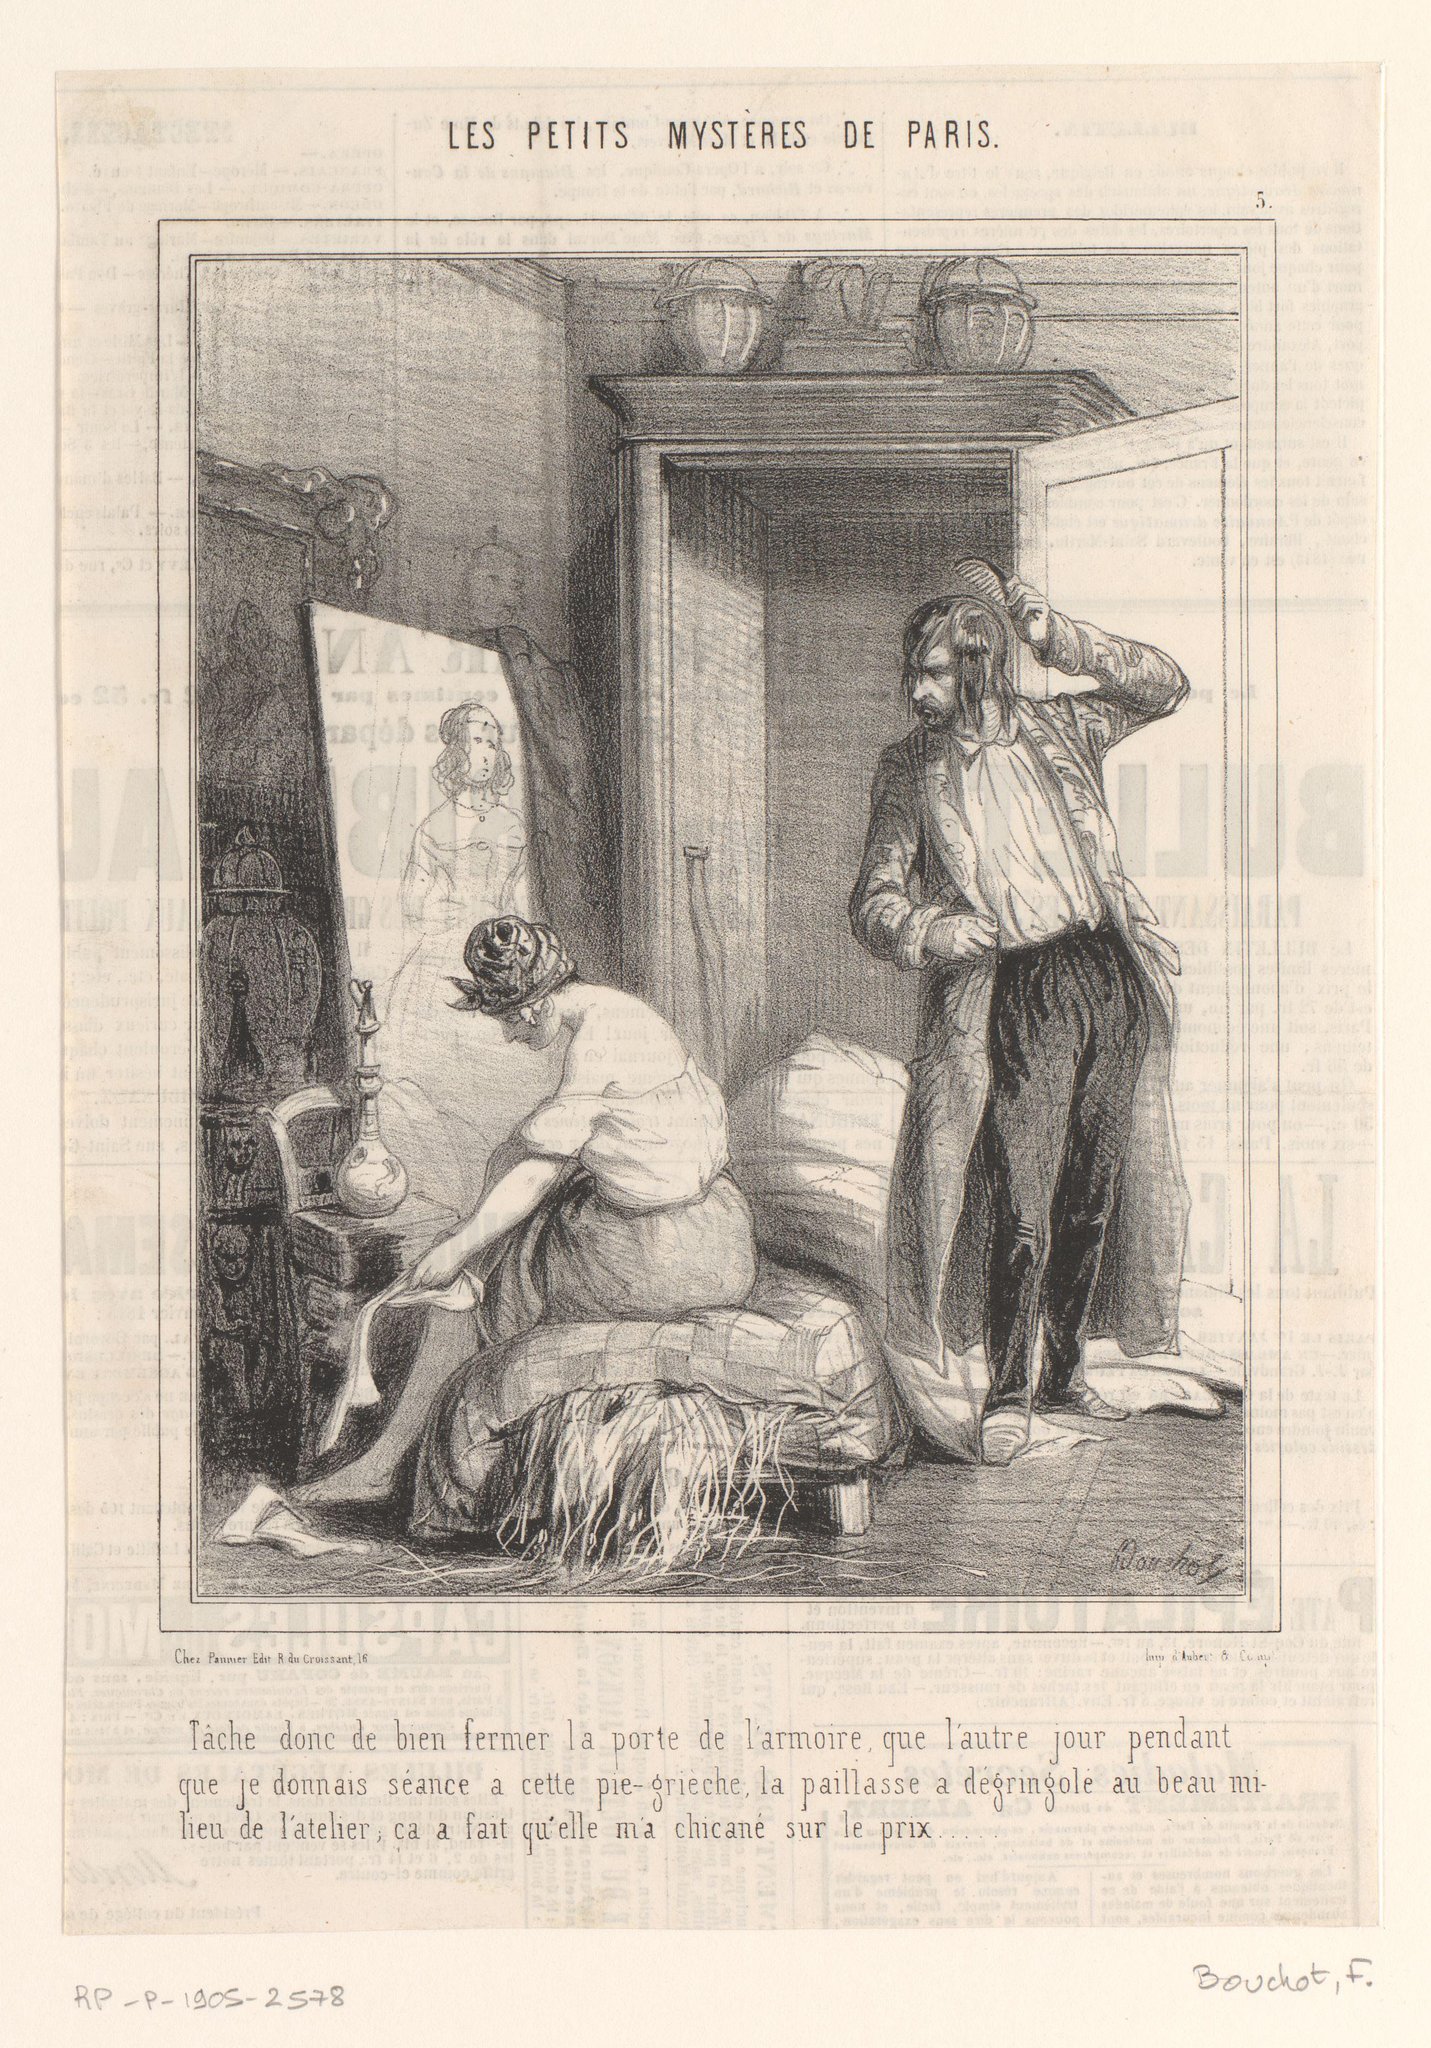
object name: cartoon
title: Tâche donc de bien fermer la porte de l'armoire (...)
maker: frédéric bouchot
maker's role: draughtsman, print maker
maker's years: 1798-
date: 1843-1844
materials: paper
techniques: lithograph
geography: paris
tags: workshop, studio ~ painter, painter in non-work situation, paris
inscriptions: collector's mark: Lugt 2228a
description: Een schilder en zijn vrouw zijn zojuist opgestaan: hij kamt zijn haar, zij trekt haar kousen aan. De schilder kijkt naar een onvoltooid portret van een vrouw, dat tegen de wand staat. Hij zegt tegen zijn vrouw dat ze de kastdeur maar goed moet sluiten. De vorige keer dat de geportretteerde vrouw ('pie-grièche', een roofvogel) kwam poseren, vloog de bank namelijk door het atelier heen, omdat ze het niet eens was over de prijs van het schilderij.